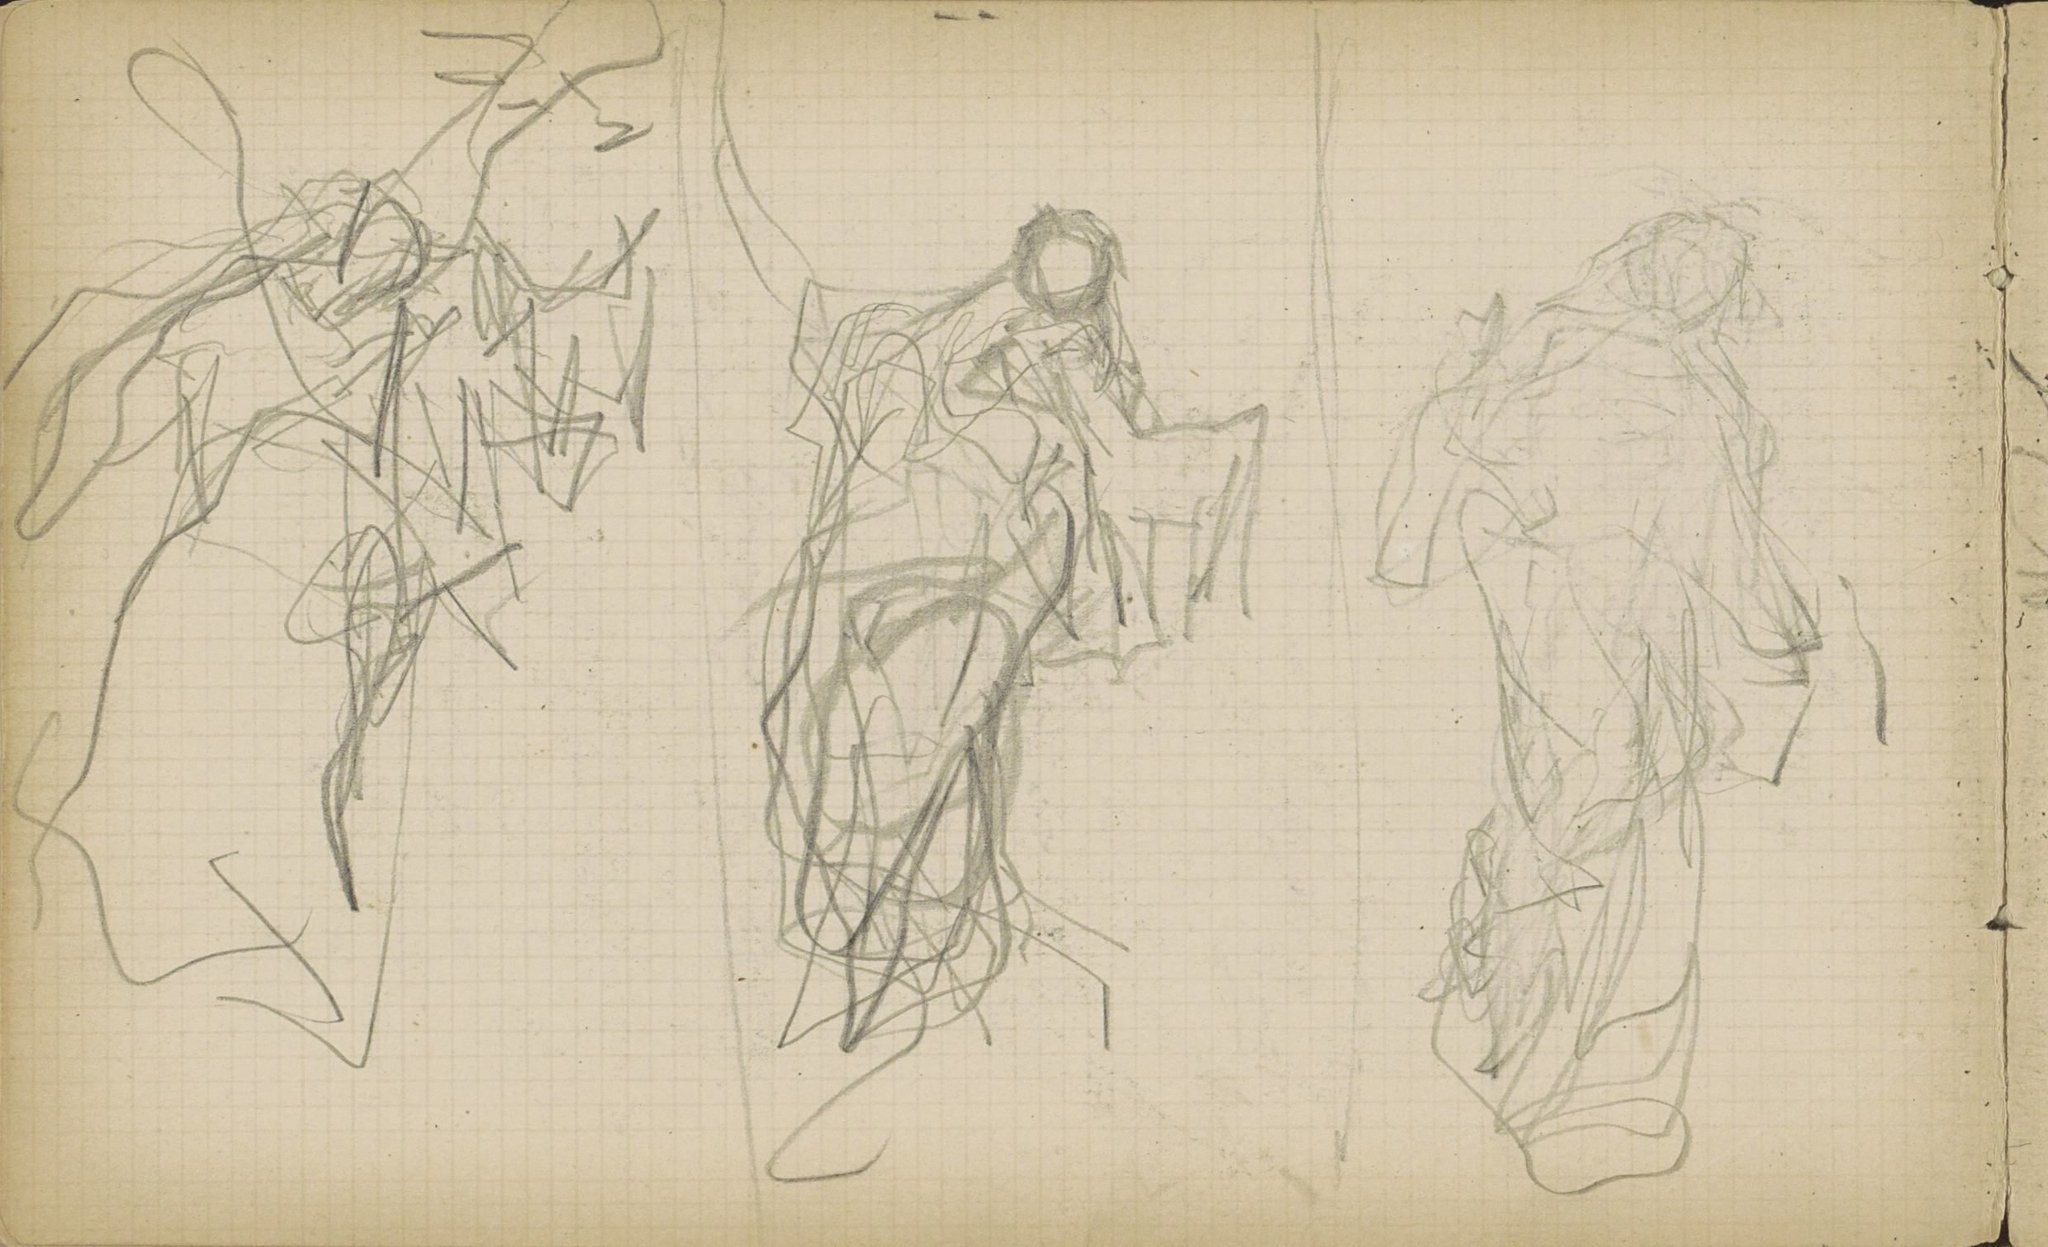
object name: sketchbook leaf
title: Staande figuren in lange gewaden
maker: matthijs maris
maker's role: draughtsman, painter, print maker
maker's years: 1839-1917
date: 1849-1917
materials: pencil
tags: standing figure, clothes, costume (+ women's clothes)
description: Blad 5 verso uit een schetsboek met 35 bladen.